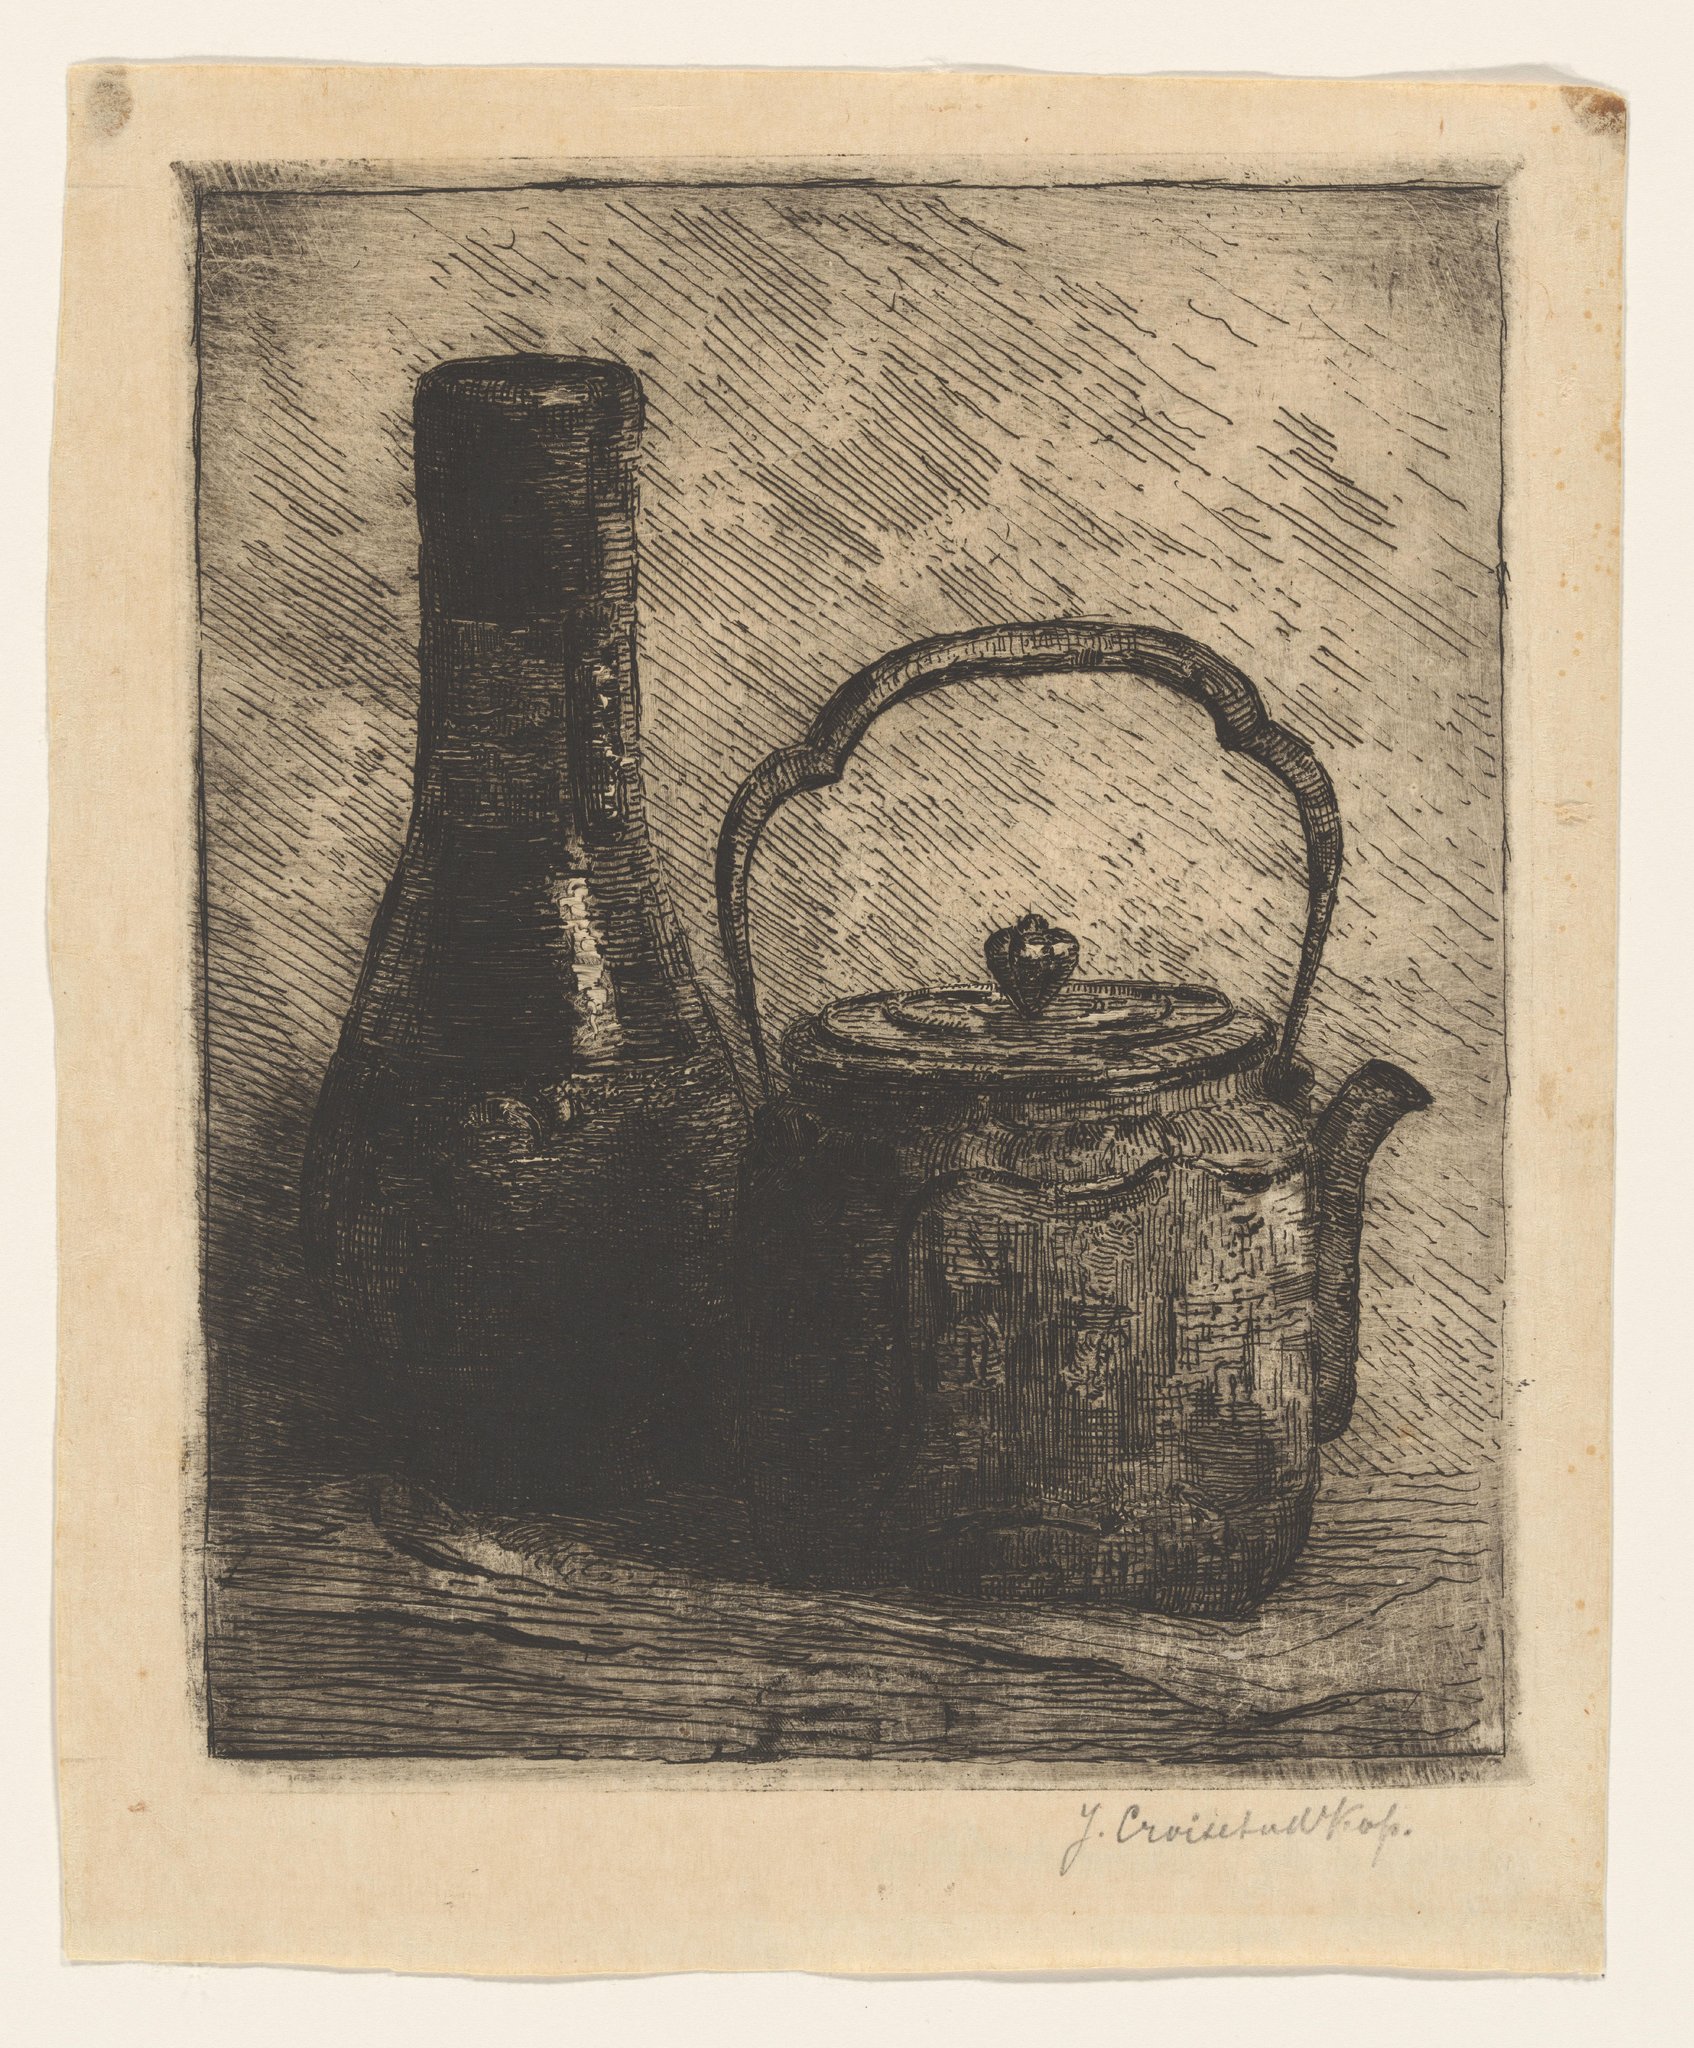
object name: print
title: Vaas en Japanse theepot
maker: johanna behrend-croiset van der kop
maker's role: draughtsman, painter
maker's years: 1861-1943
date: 1880-1900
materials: paper, pencil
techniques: etching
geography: netherlands